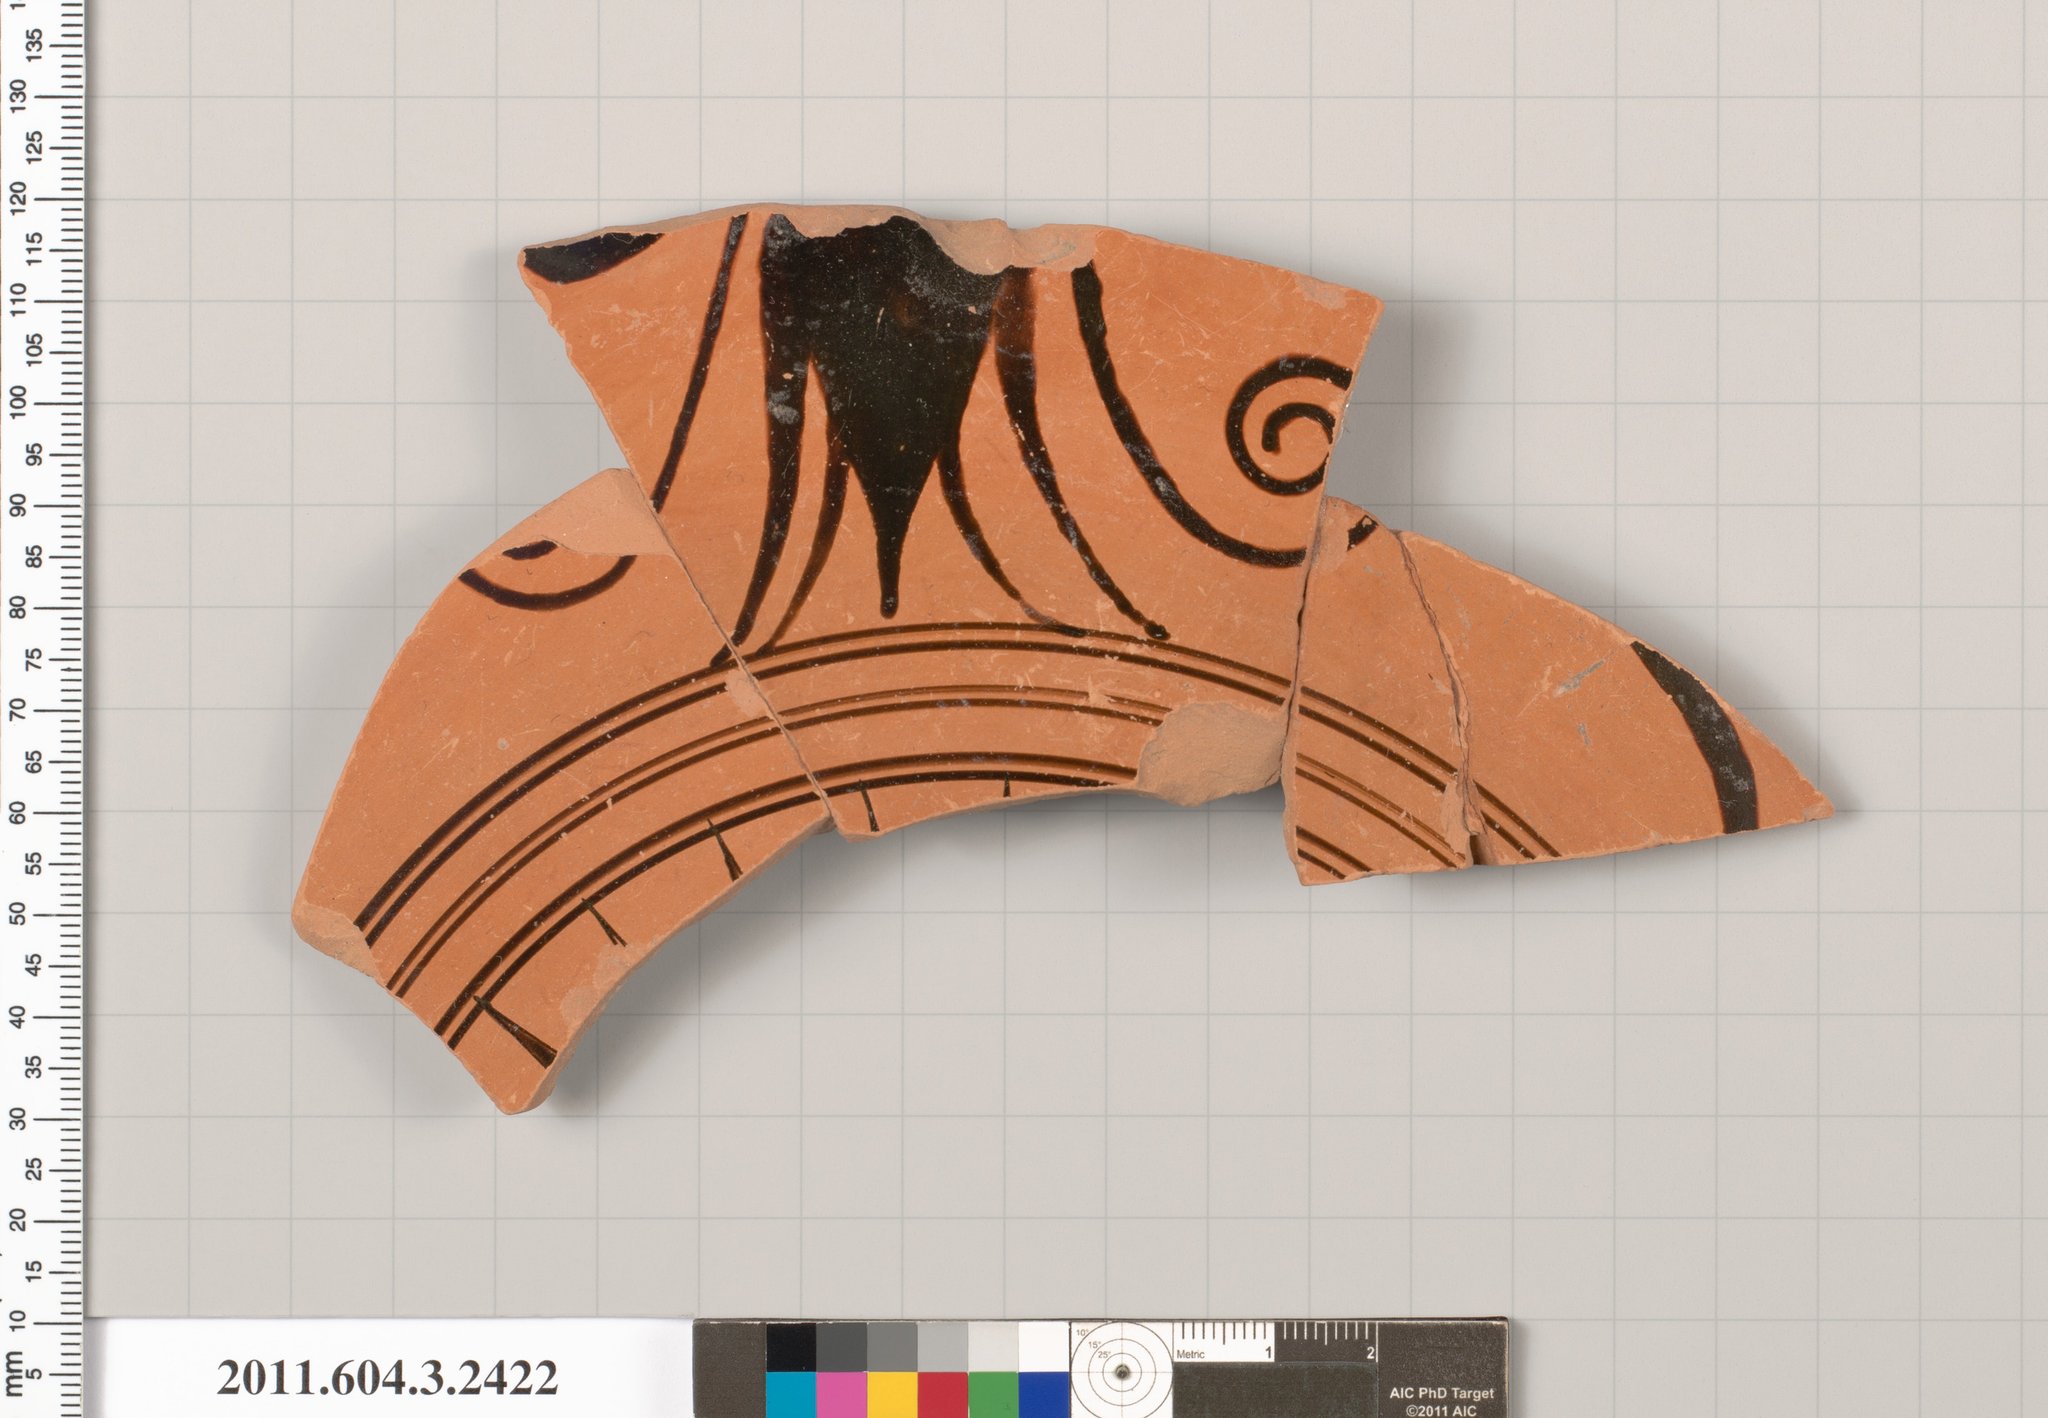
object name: kylix fragment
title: Terracotta fragment of a kylix: eye-cup (drinking cup)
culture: greek, attic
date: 530-520 BCE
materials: terracotta